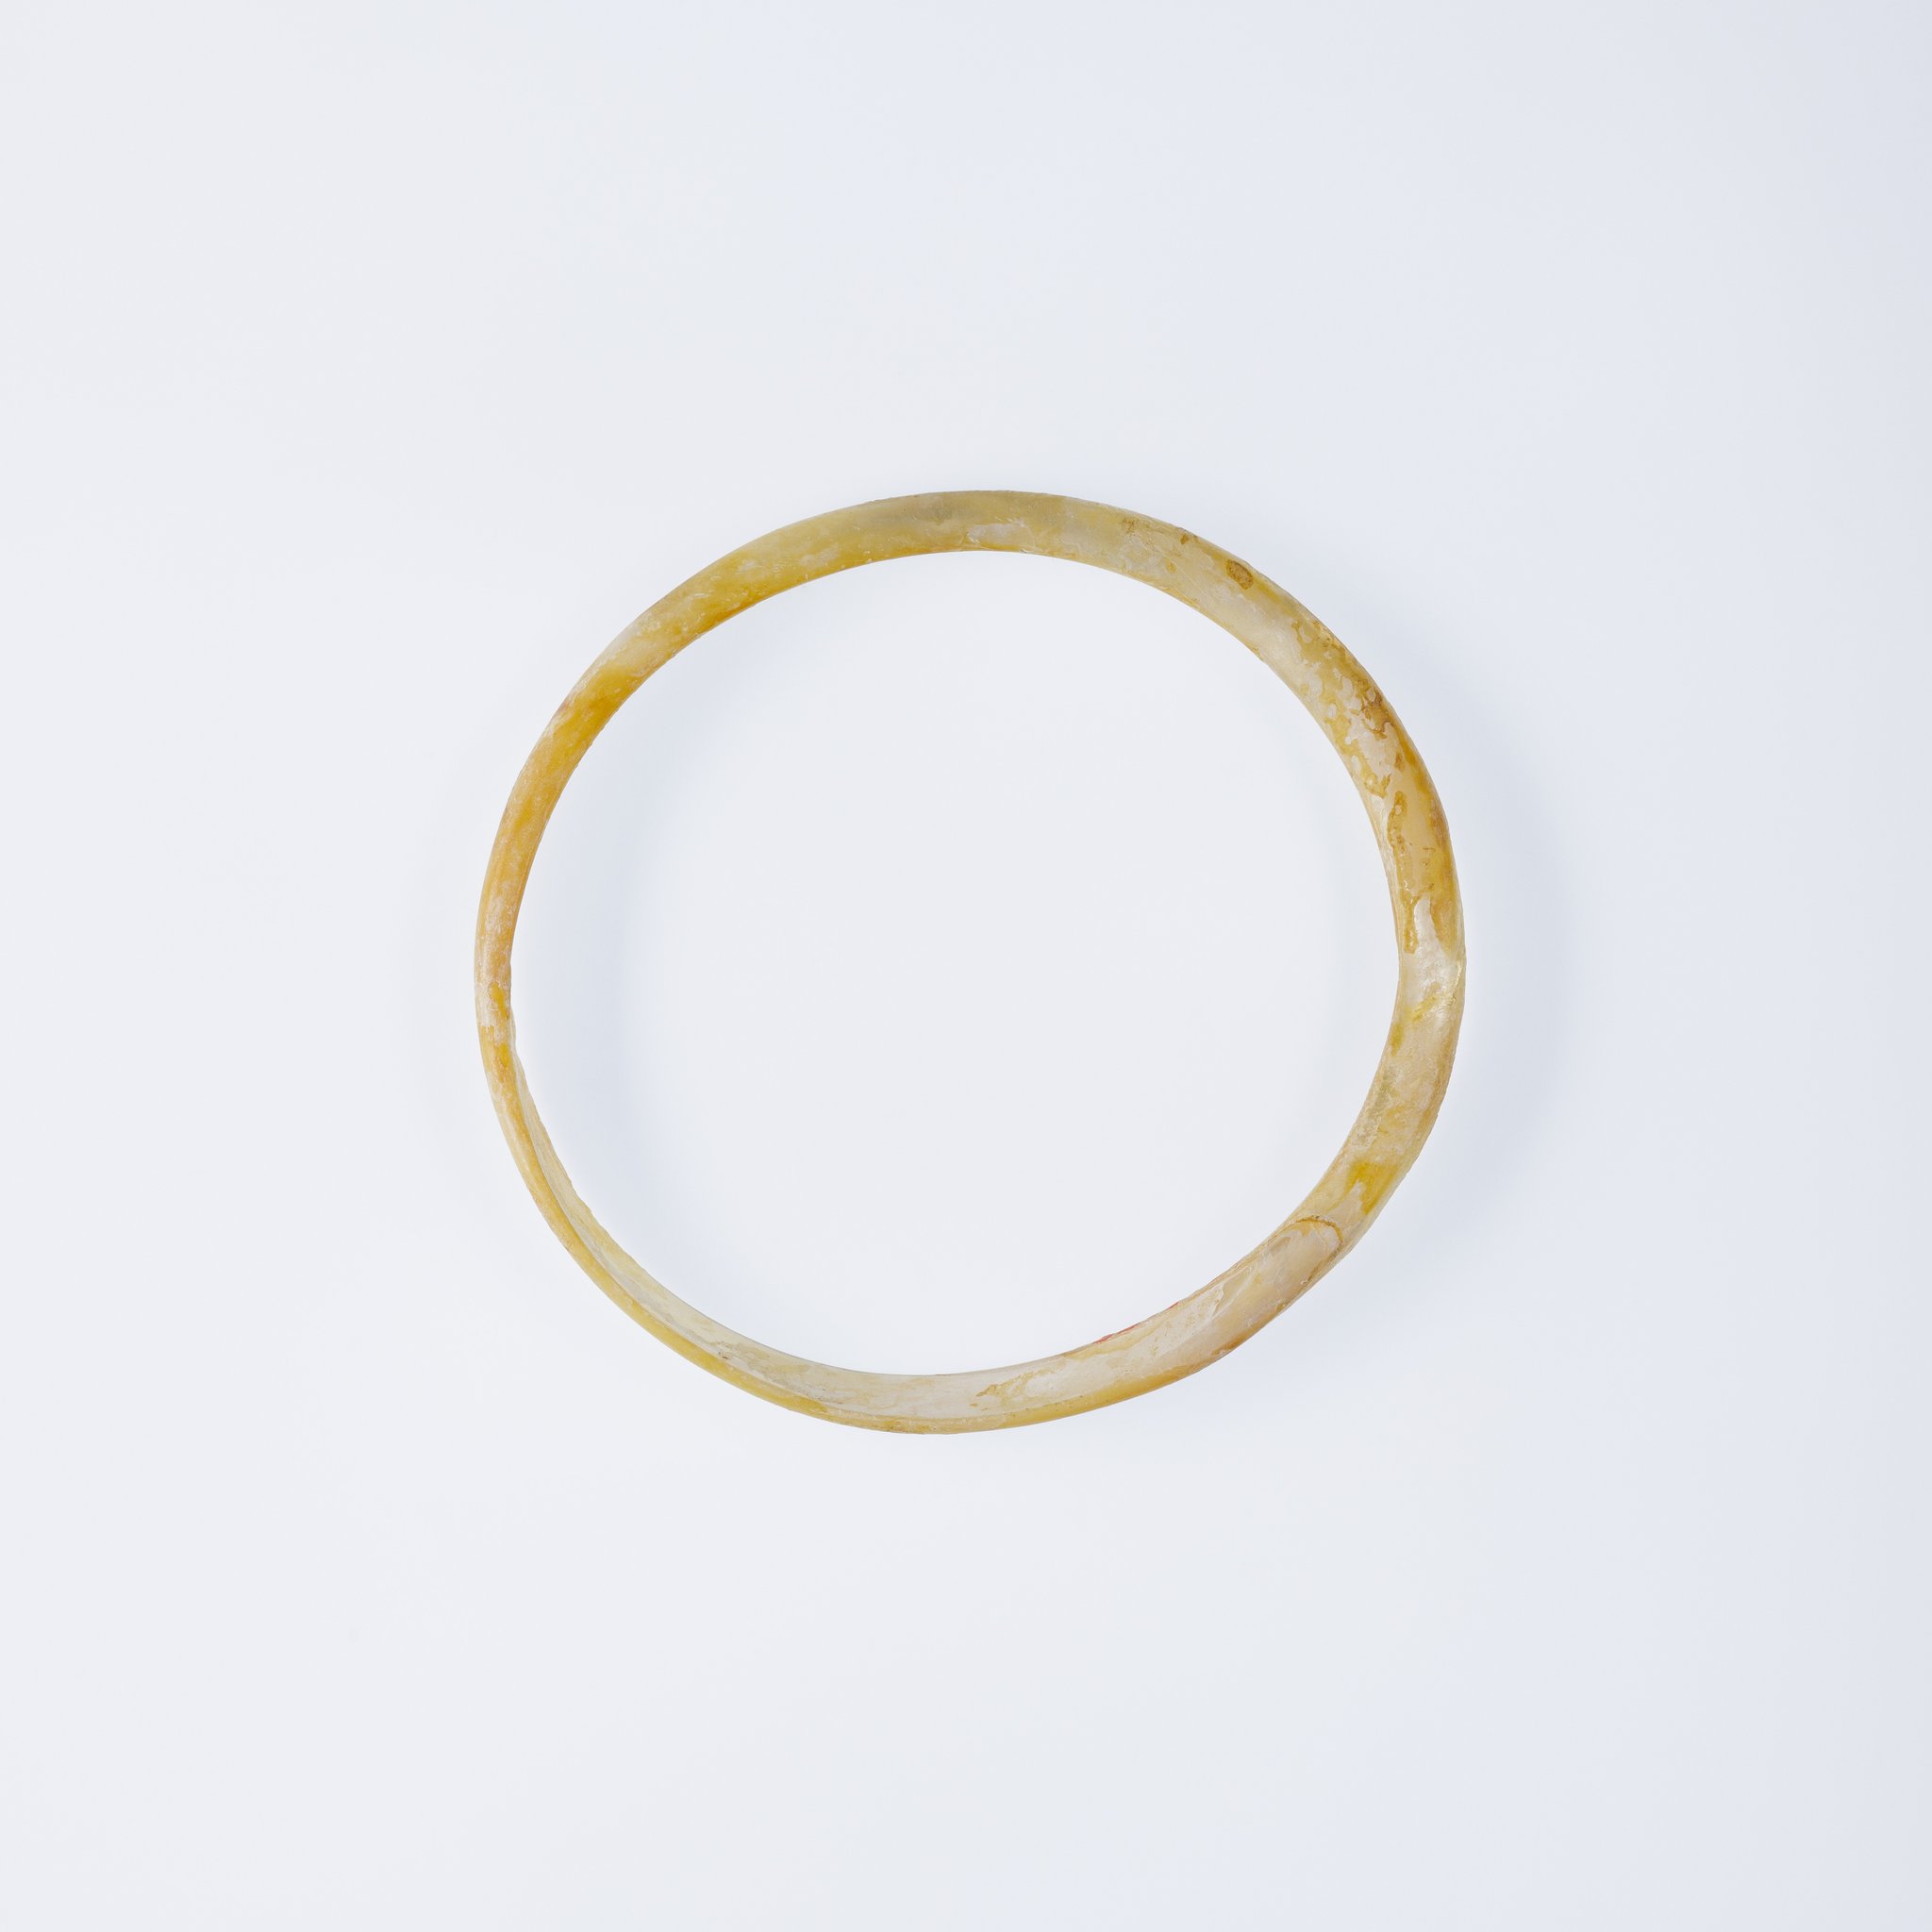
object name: bracelet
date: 2960-2649 BCE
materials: shell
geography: egypt